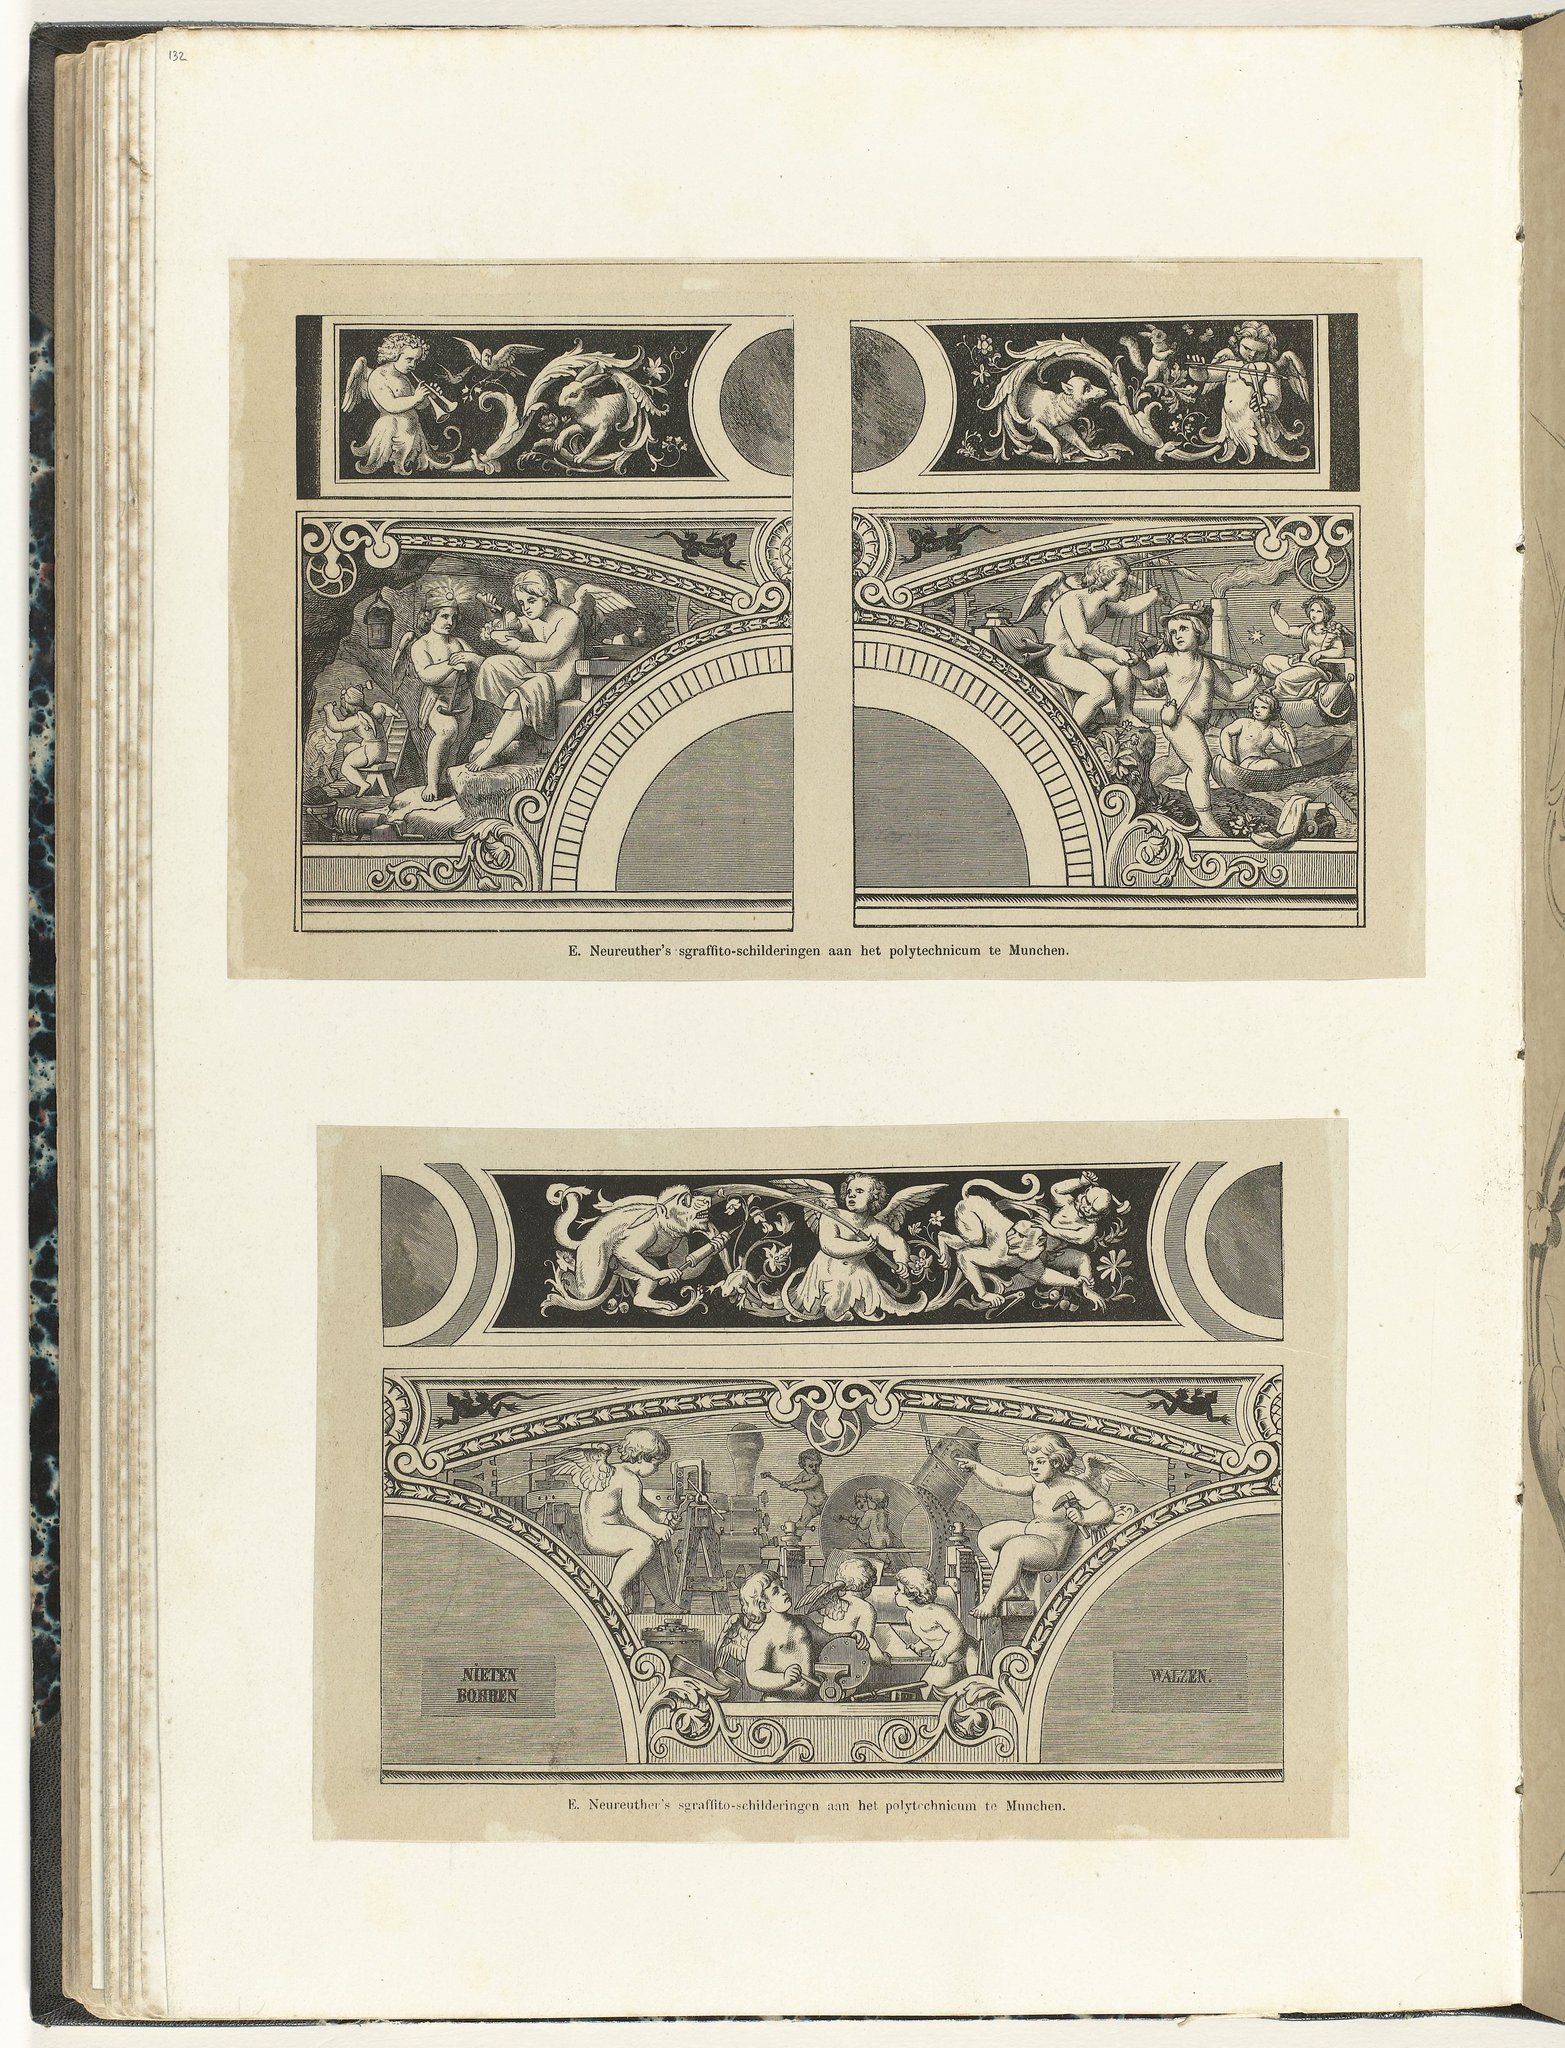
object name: print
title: Nieten Bohren / Walzen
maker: Anonymous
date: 1866-1900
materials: paper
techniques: engraving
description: Op de prent bovenaan staan een fries en een paneel afgebeeld, opgesplitst in twee delen. Op het linkerdeel van het paneel is een steenhouwerij te zien. Op de prent onderaan staat een fries met drie apen afgebeeld en een omlijsting met acht putti. Onder beide prenten staat: E. Neureuther's sgraffito(-)schilderingen aan het polytechnicum te Munchen.